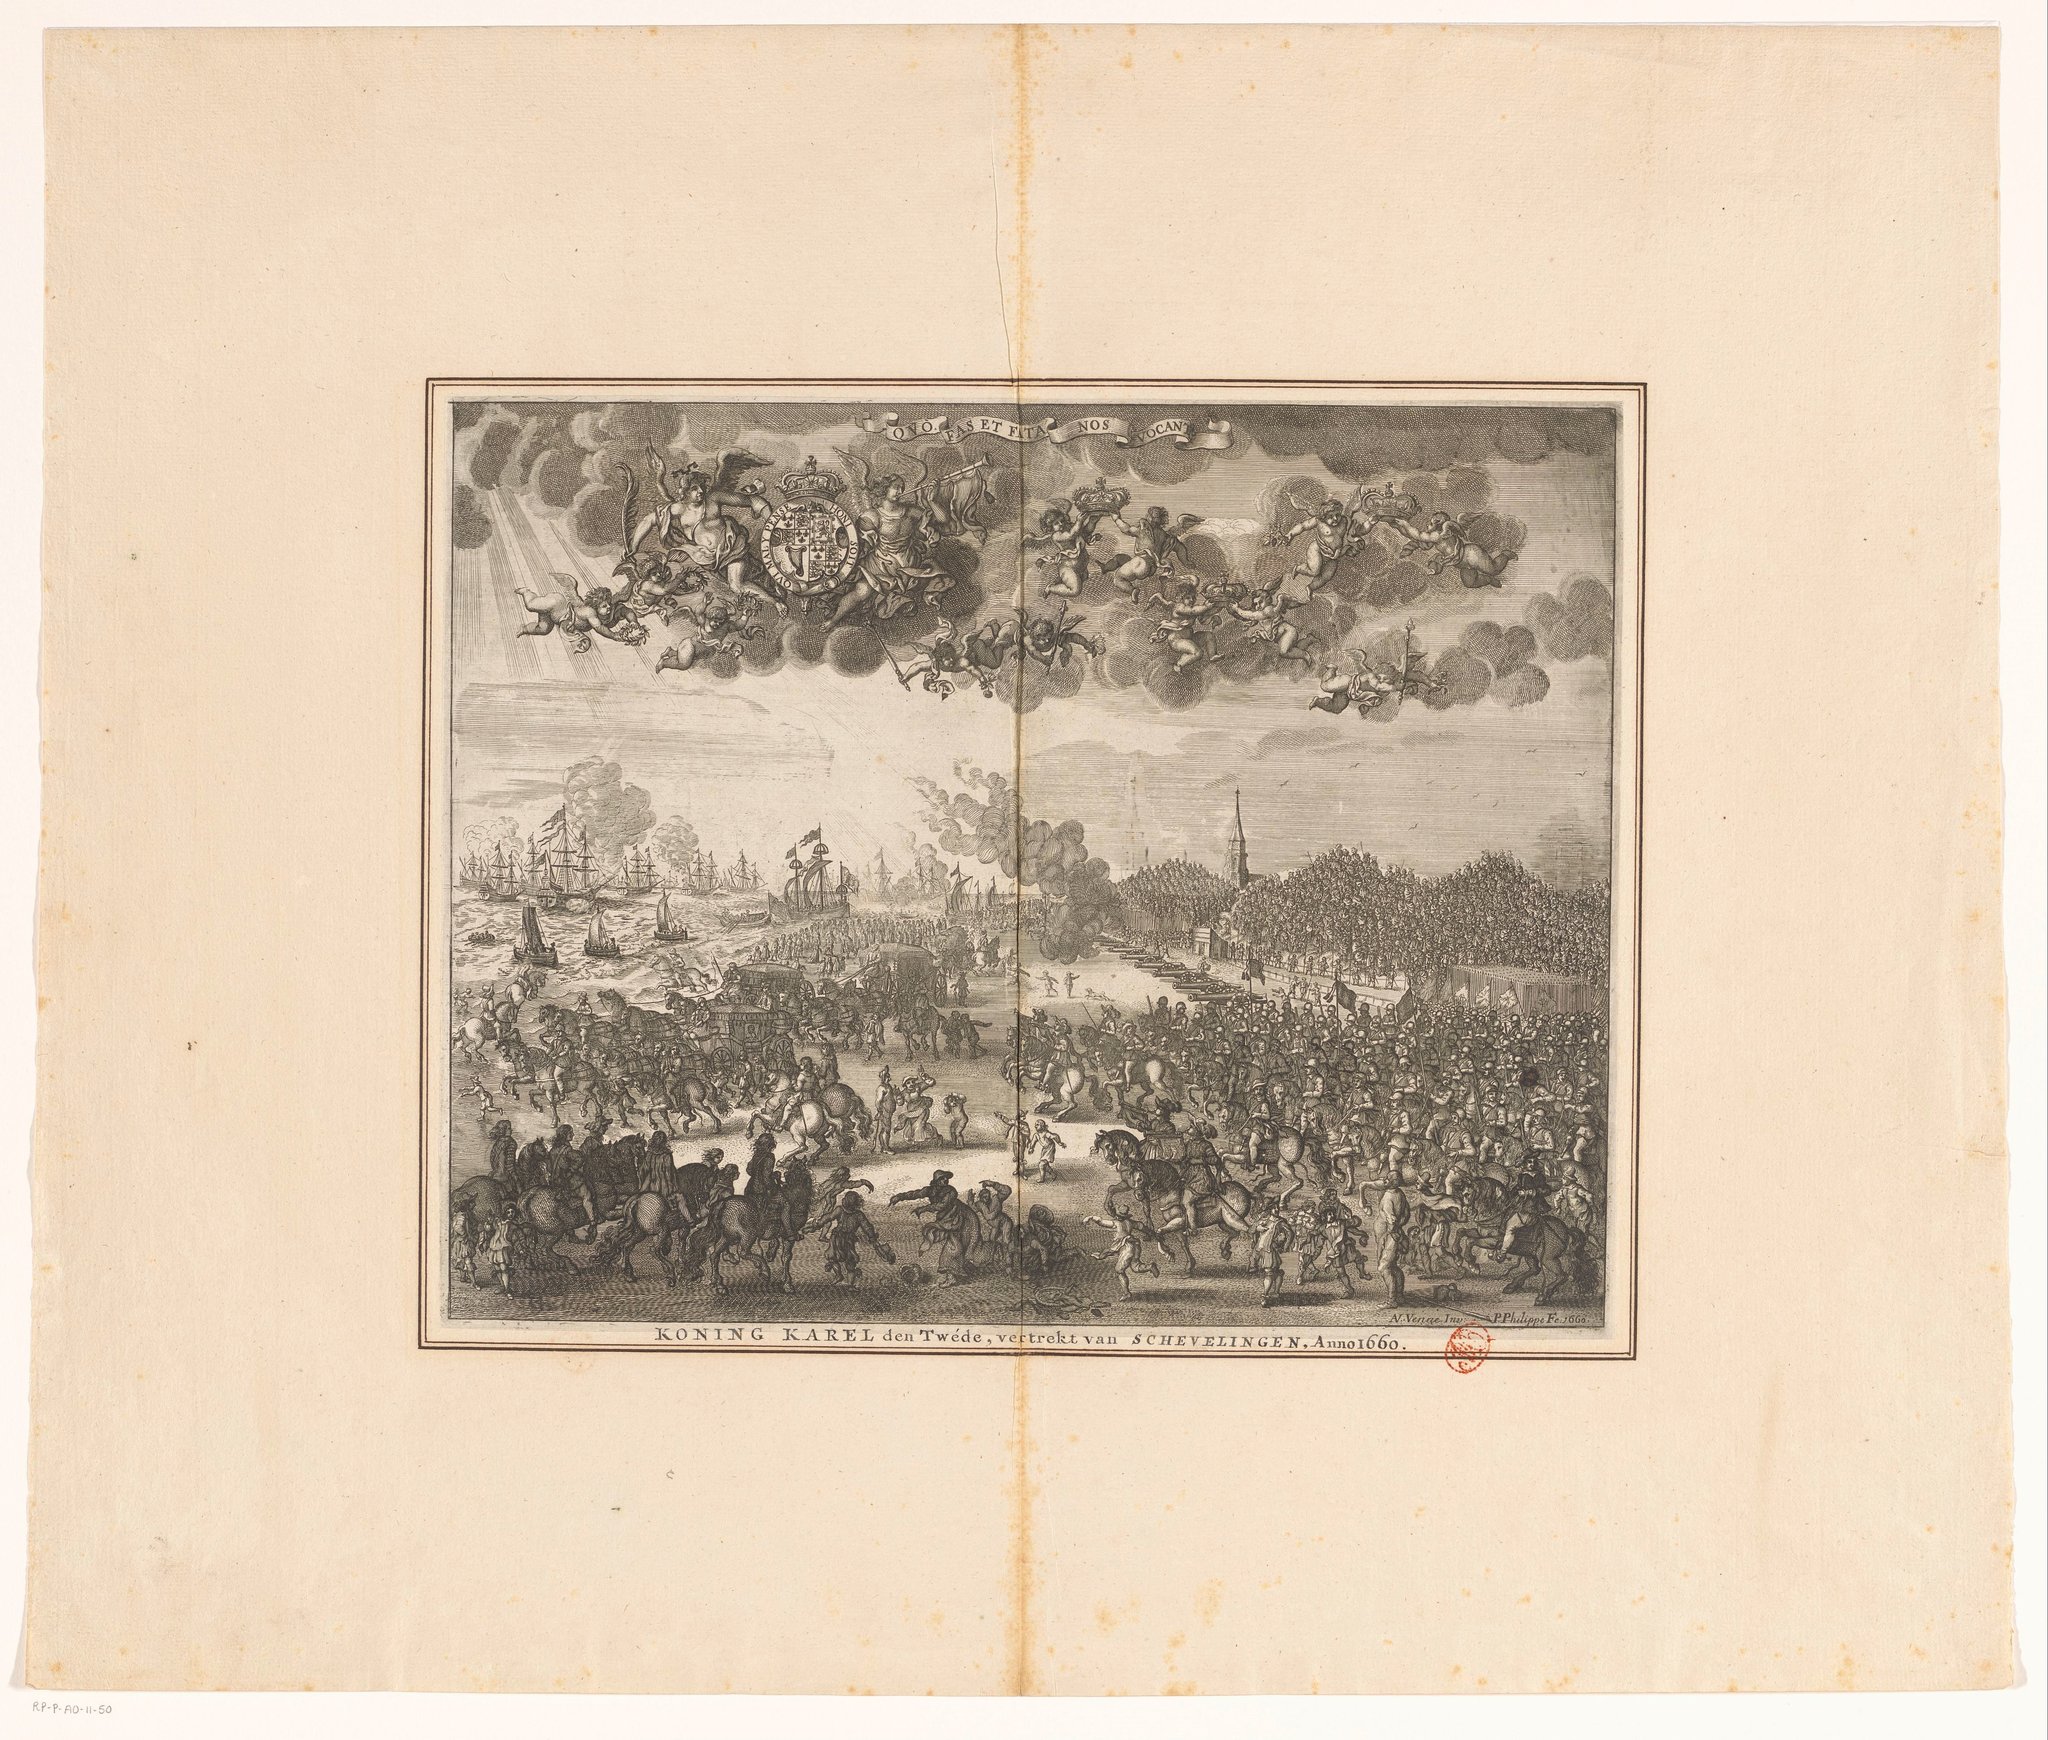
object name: print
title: Vertrek van Karel II uit Scheveningen naar Engeland, 1660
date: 1660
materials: ink, paper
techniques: engraving, etching, pen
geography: the hague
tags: london, karel ii (koning van engeland), departure ~ travelling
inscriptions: inscription: ‘Koning Karel den Twéde, vertrekt van Schevelingen, anno 1660’, collector's mark: Lugt 195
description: Het vertrek van de Engelse koning Karel II vanuit Scheveningen naar Engeland, 2 juni 1660. Episode tijdens zijn rondreis door en vertrek uit de Nederlanden. Links de koetsen met de koning en zijn gevolg, rechts ruiters, kanonnen en toeschouwers op de duinen. Op zee wachten de schepen om de koning naar Engeland te brengen. In de lucht putti en de Faam met het wapen van de Engelse koning en een banderol met Latijnse spreuk.